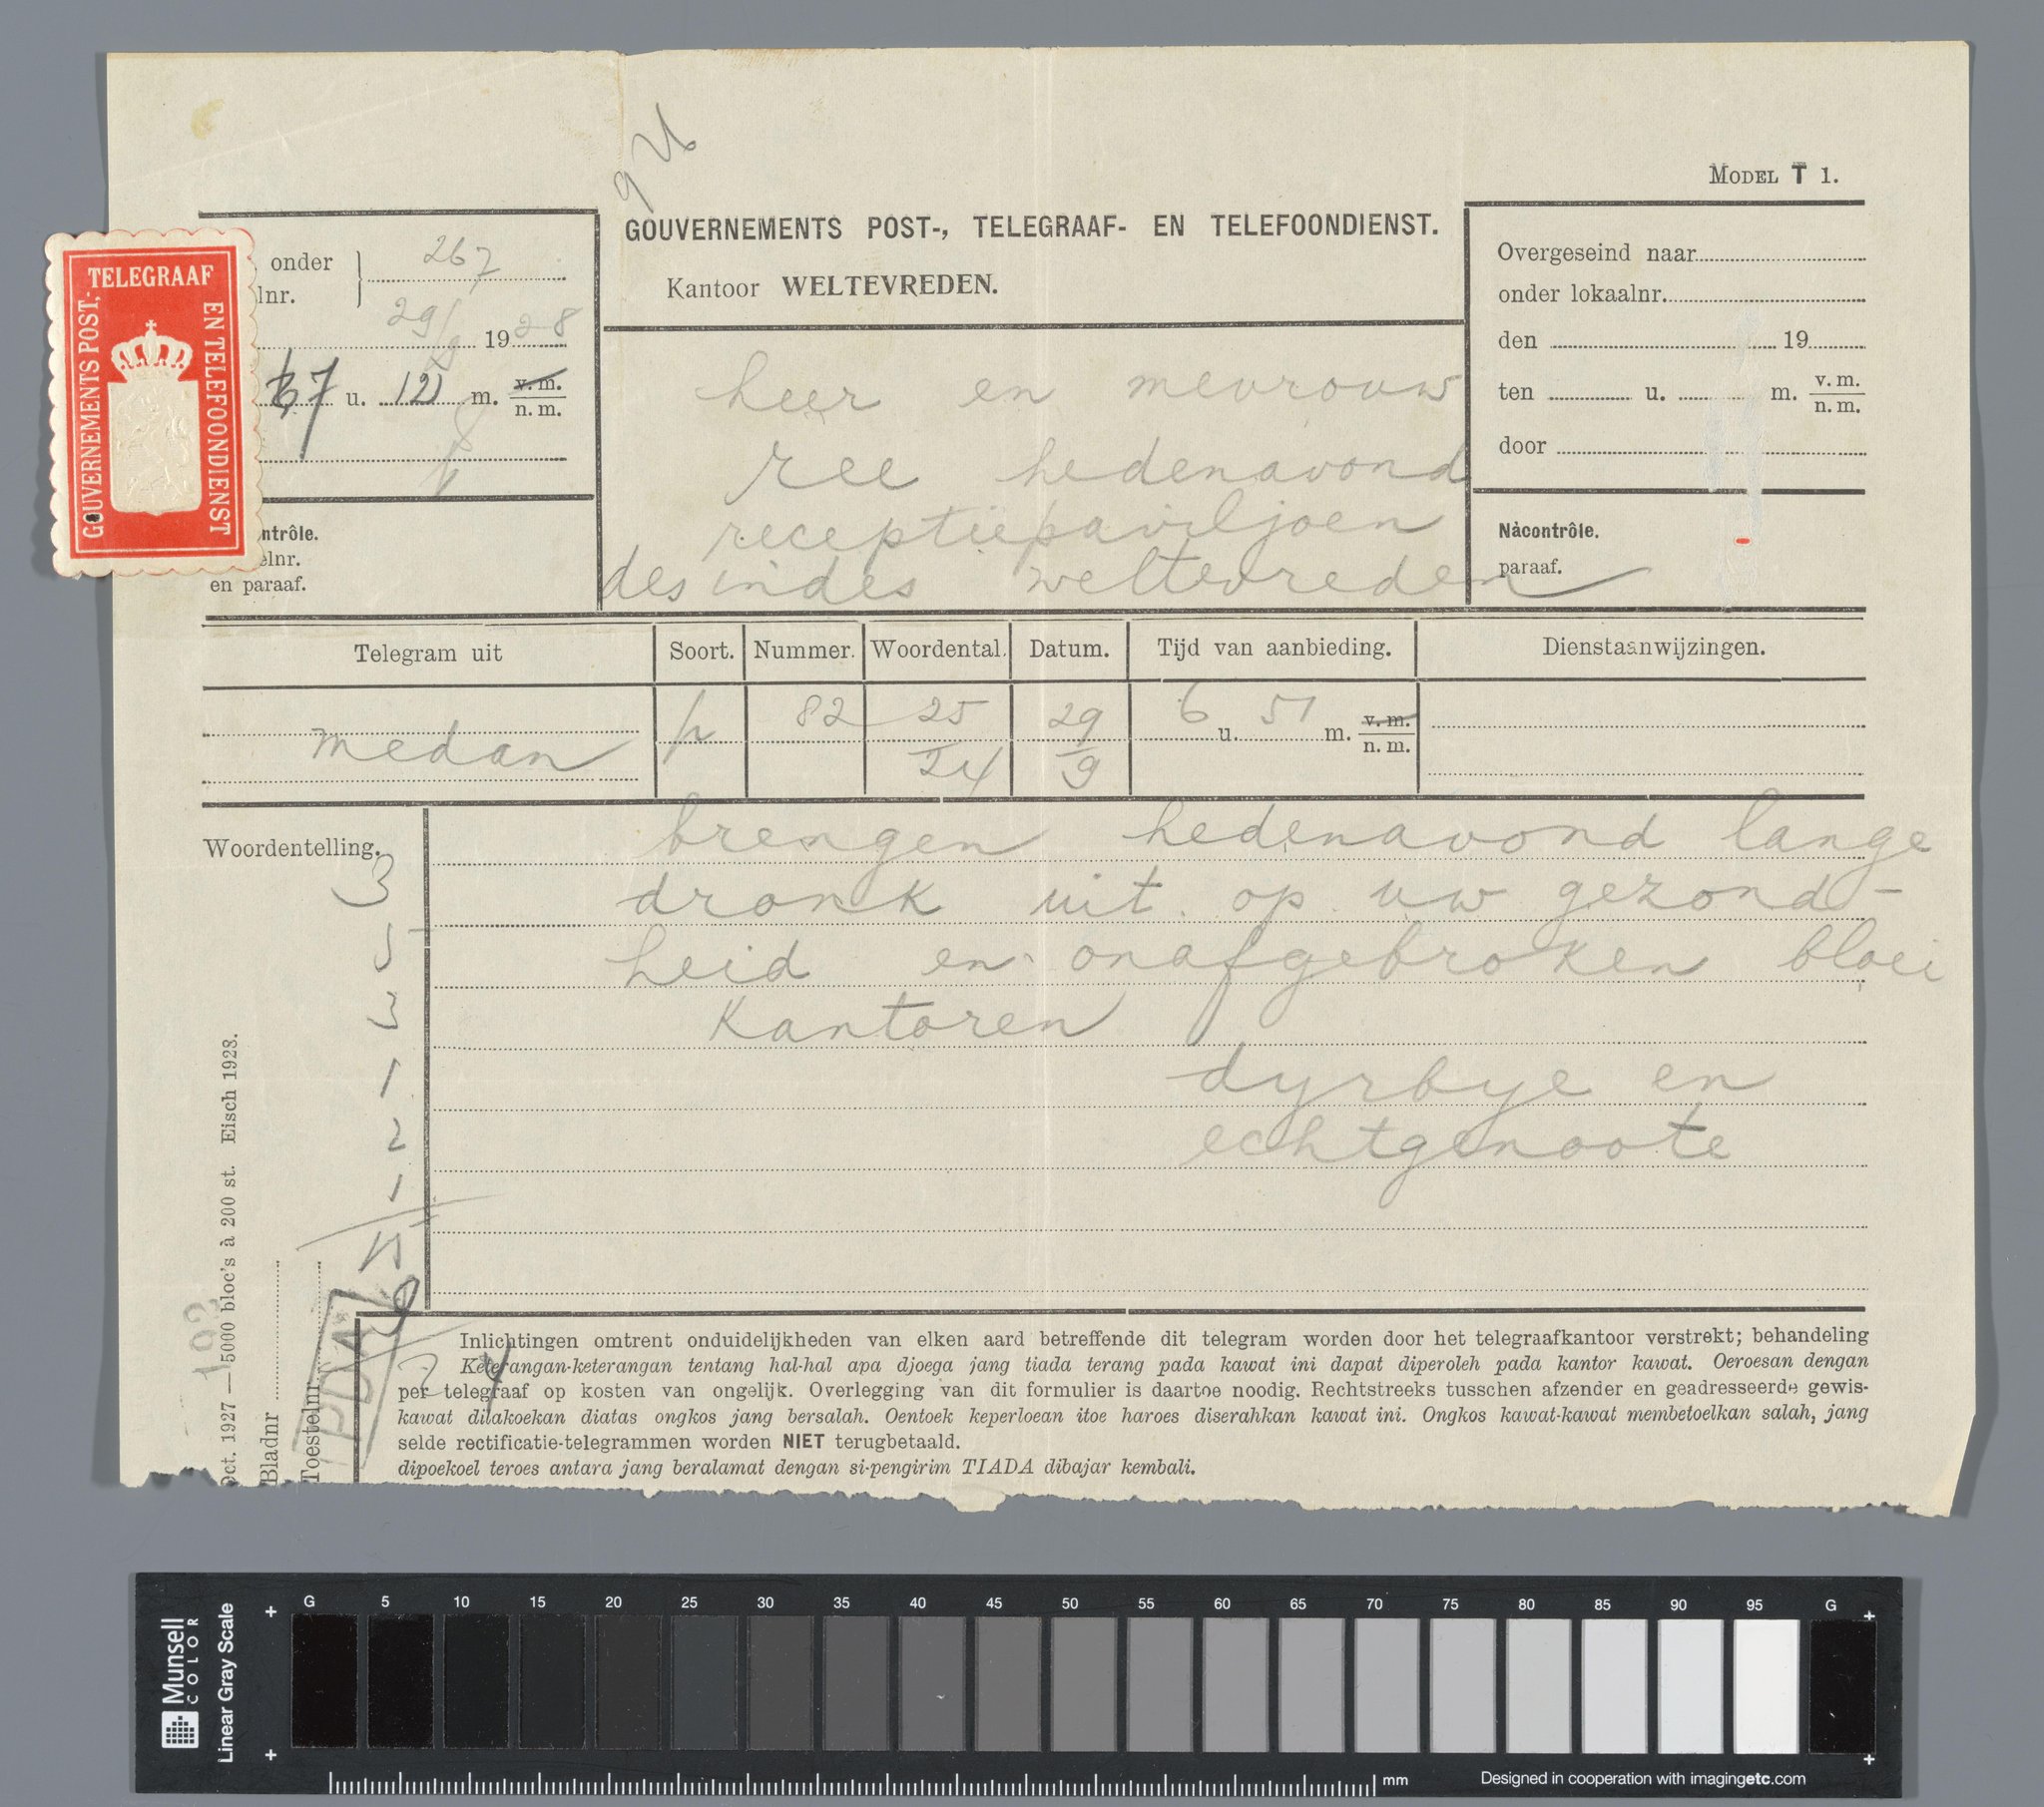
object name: telegram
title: Telegram met gelukwensen, 1928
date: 1928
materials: paper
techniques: typewriting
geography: weltevreden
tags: batavia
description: Telegram met gelukwensen namens "dyrbye en echtgenoote", verzonden vanuit Medan op 29 september 1928. Document van Gouvernements Post-, Telegraaf- en Telefoondienst, kantoor Weltevreden, met gedrukte en getypte tekst, stempels en een verbroken zegel. Behoort bij het herinneringsalbum aangeboden aan Willem Ree van accountantsbureau Frese & Hogeweg bij zijn vertrek bij het kantoor in Weltevreden op 30 september 1928.